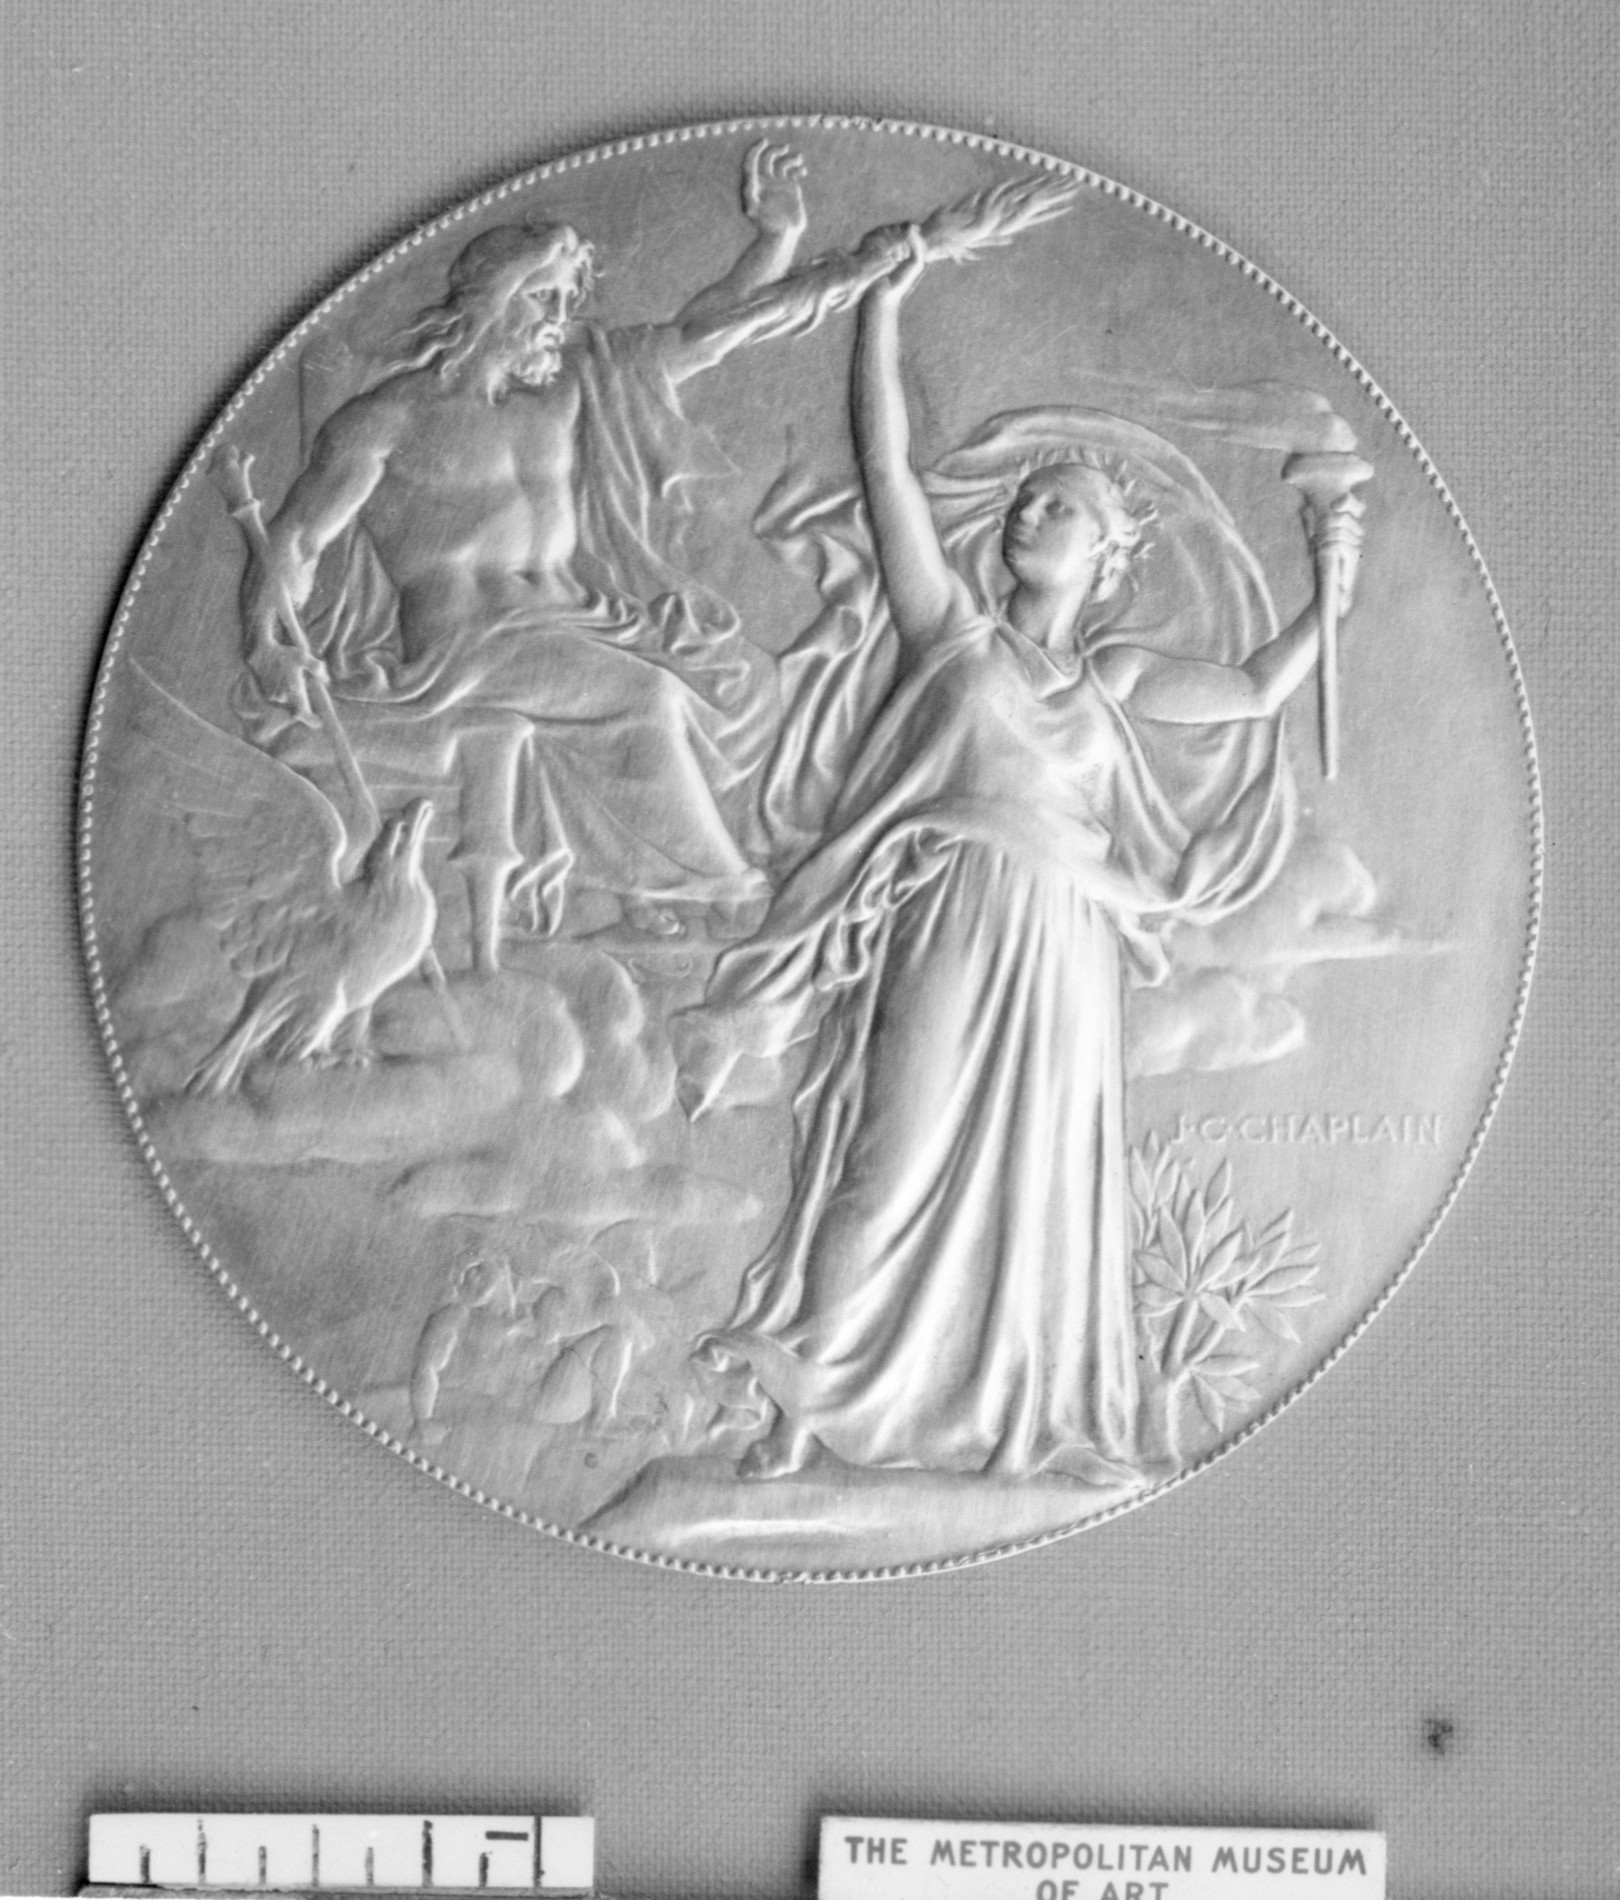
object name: medal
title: International Congress of Electricians, at Paris, 1881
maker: jules-clément chaplain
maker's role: artist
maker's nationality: french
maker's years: 1839-1909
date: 1881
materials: bronze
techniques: silvered, struck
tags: birds,men,women